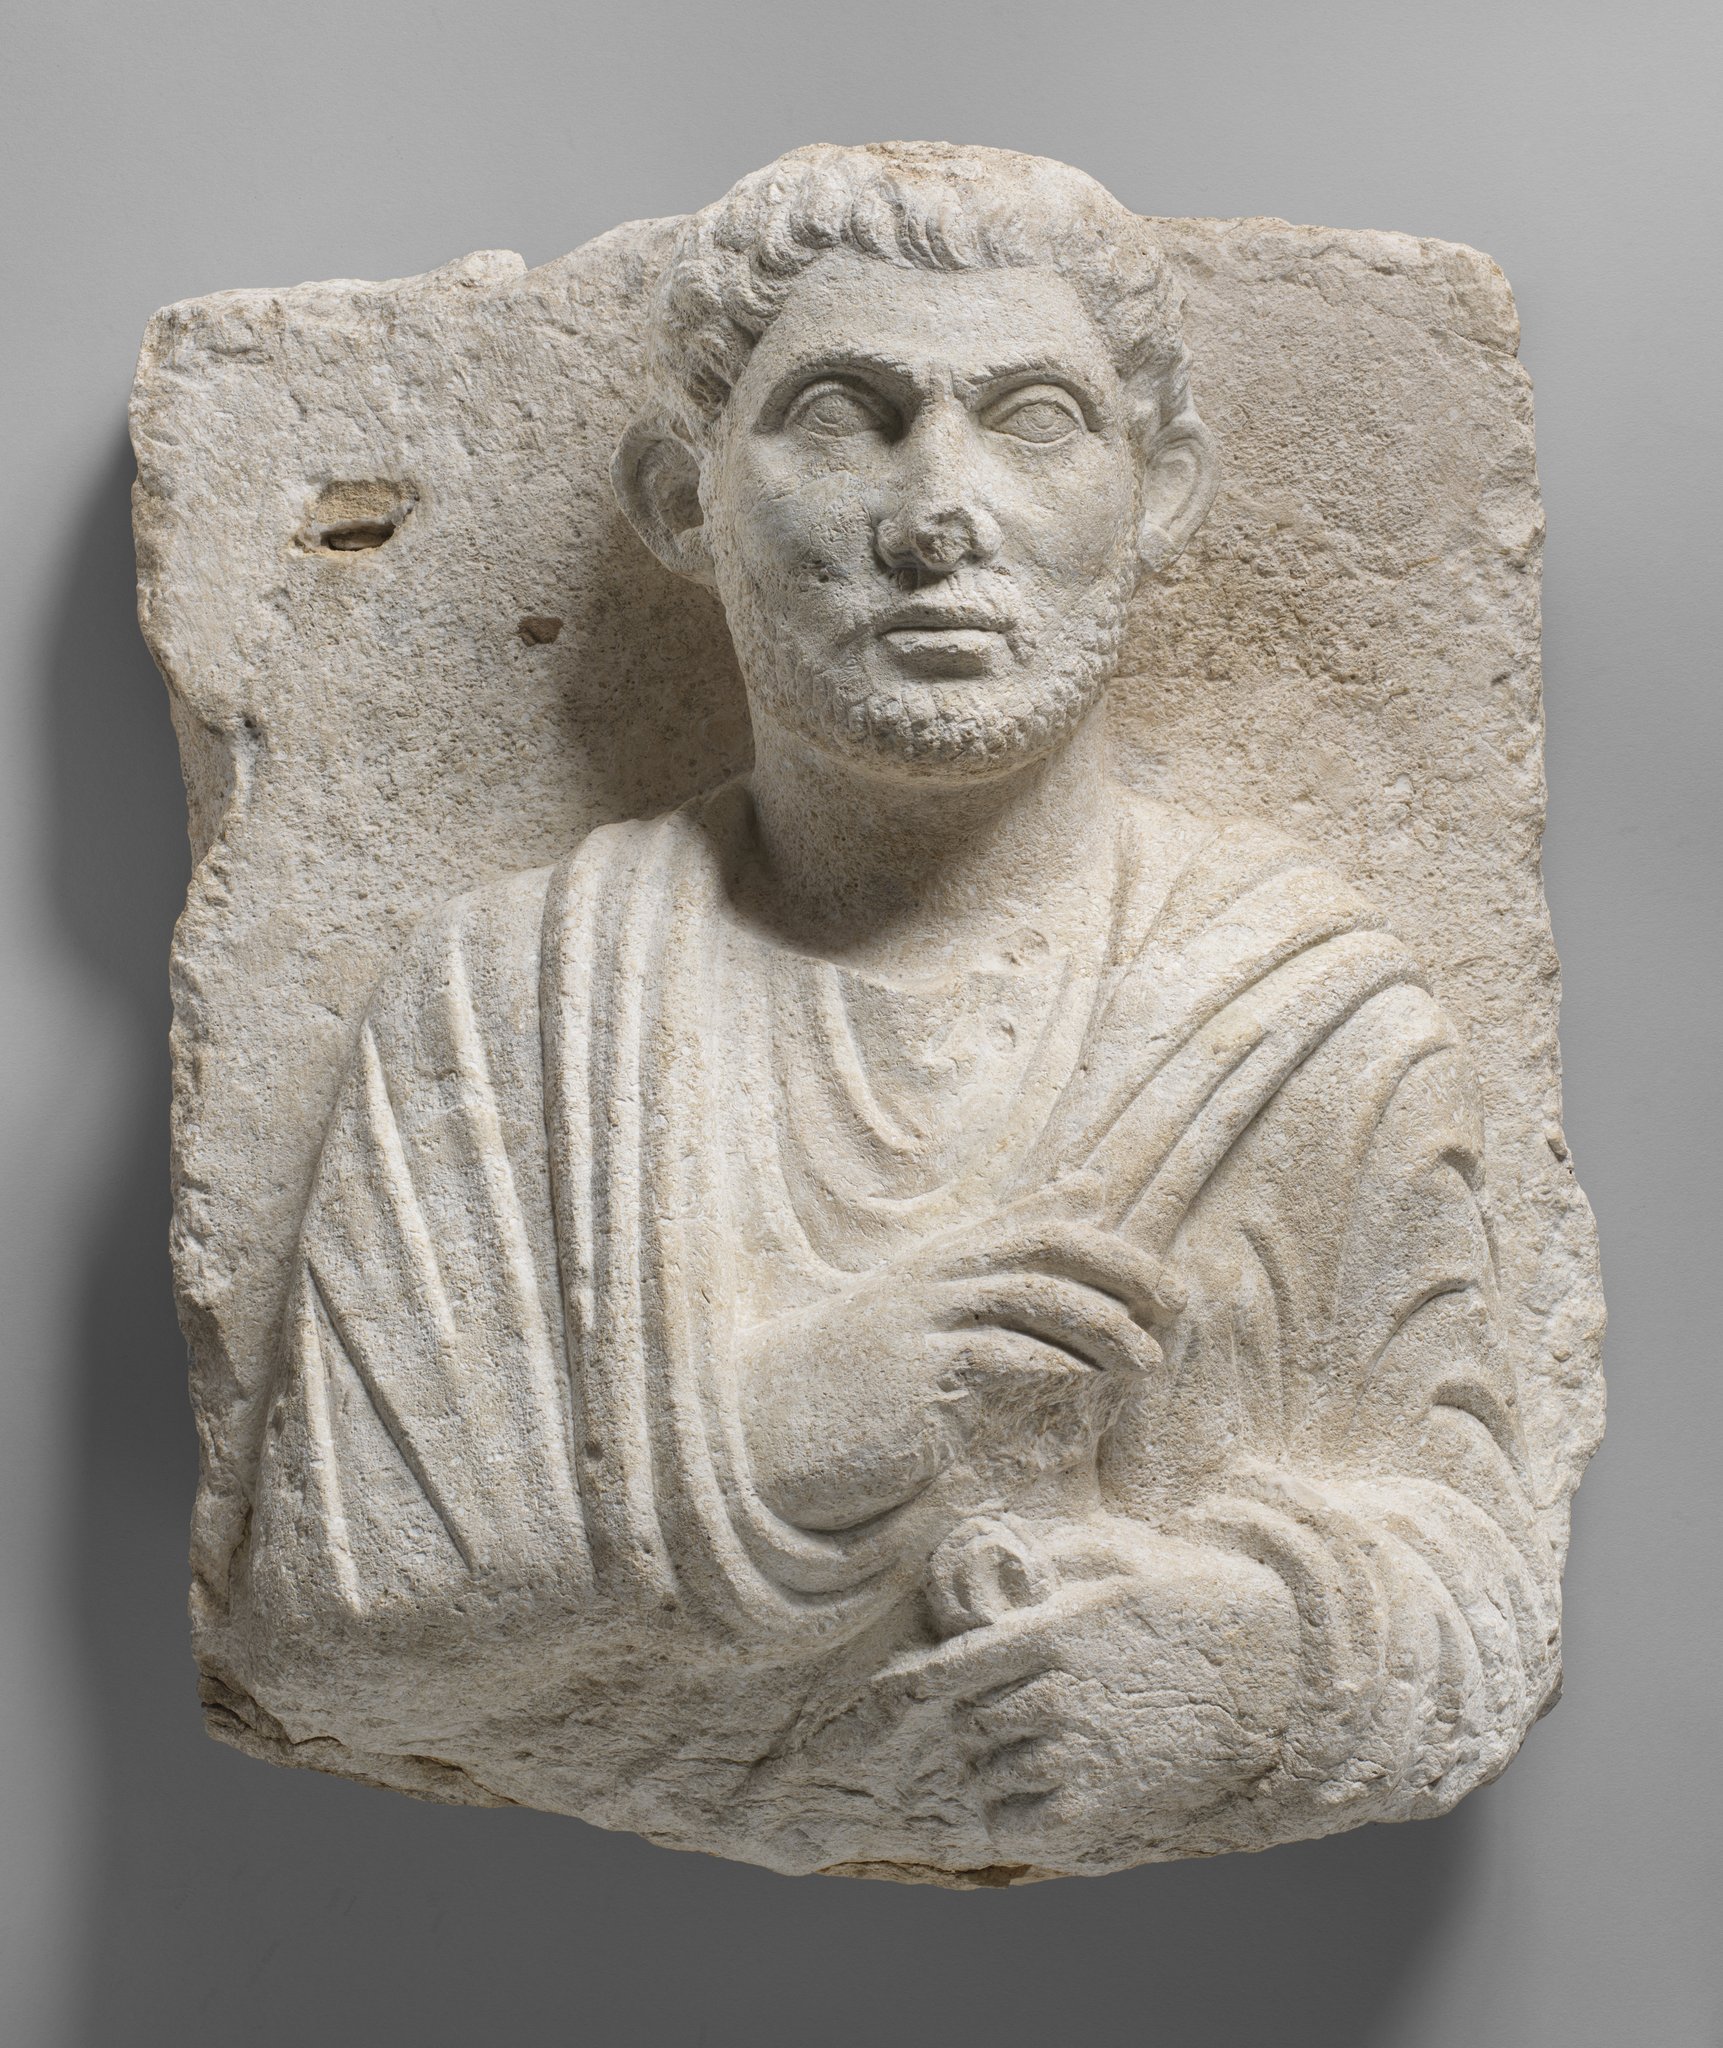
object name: funerary relief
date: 200-273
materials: limestone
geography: syria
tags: men